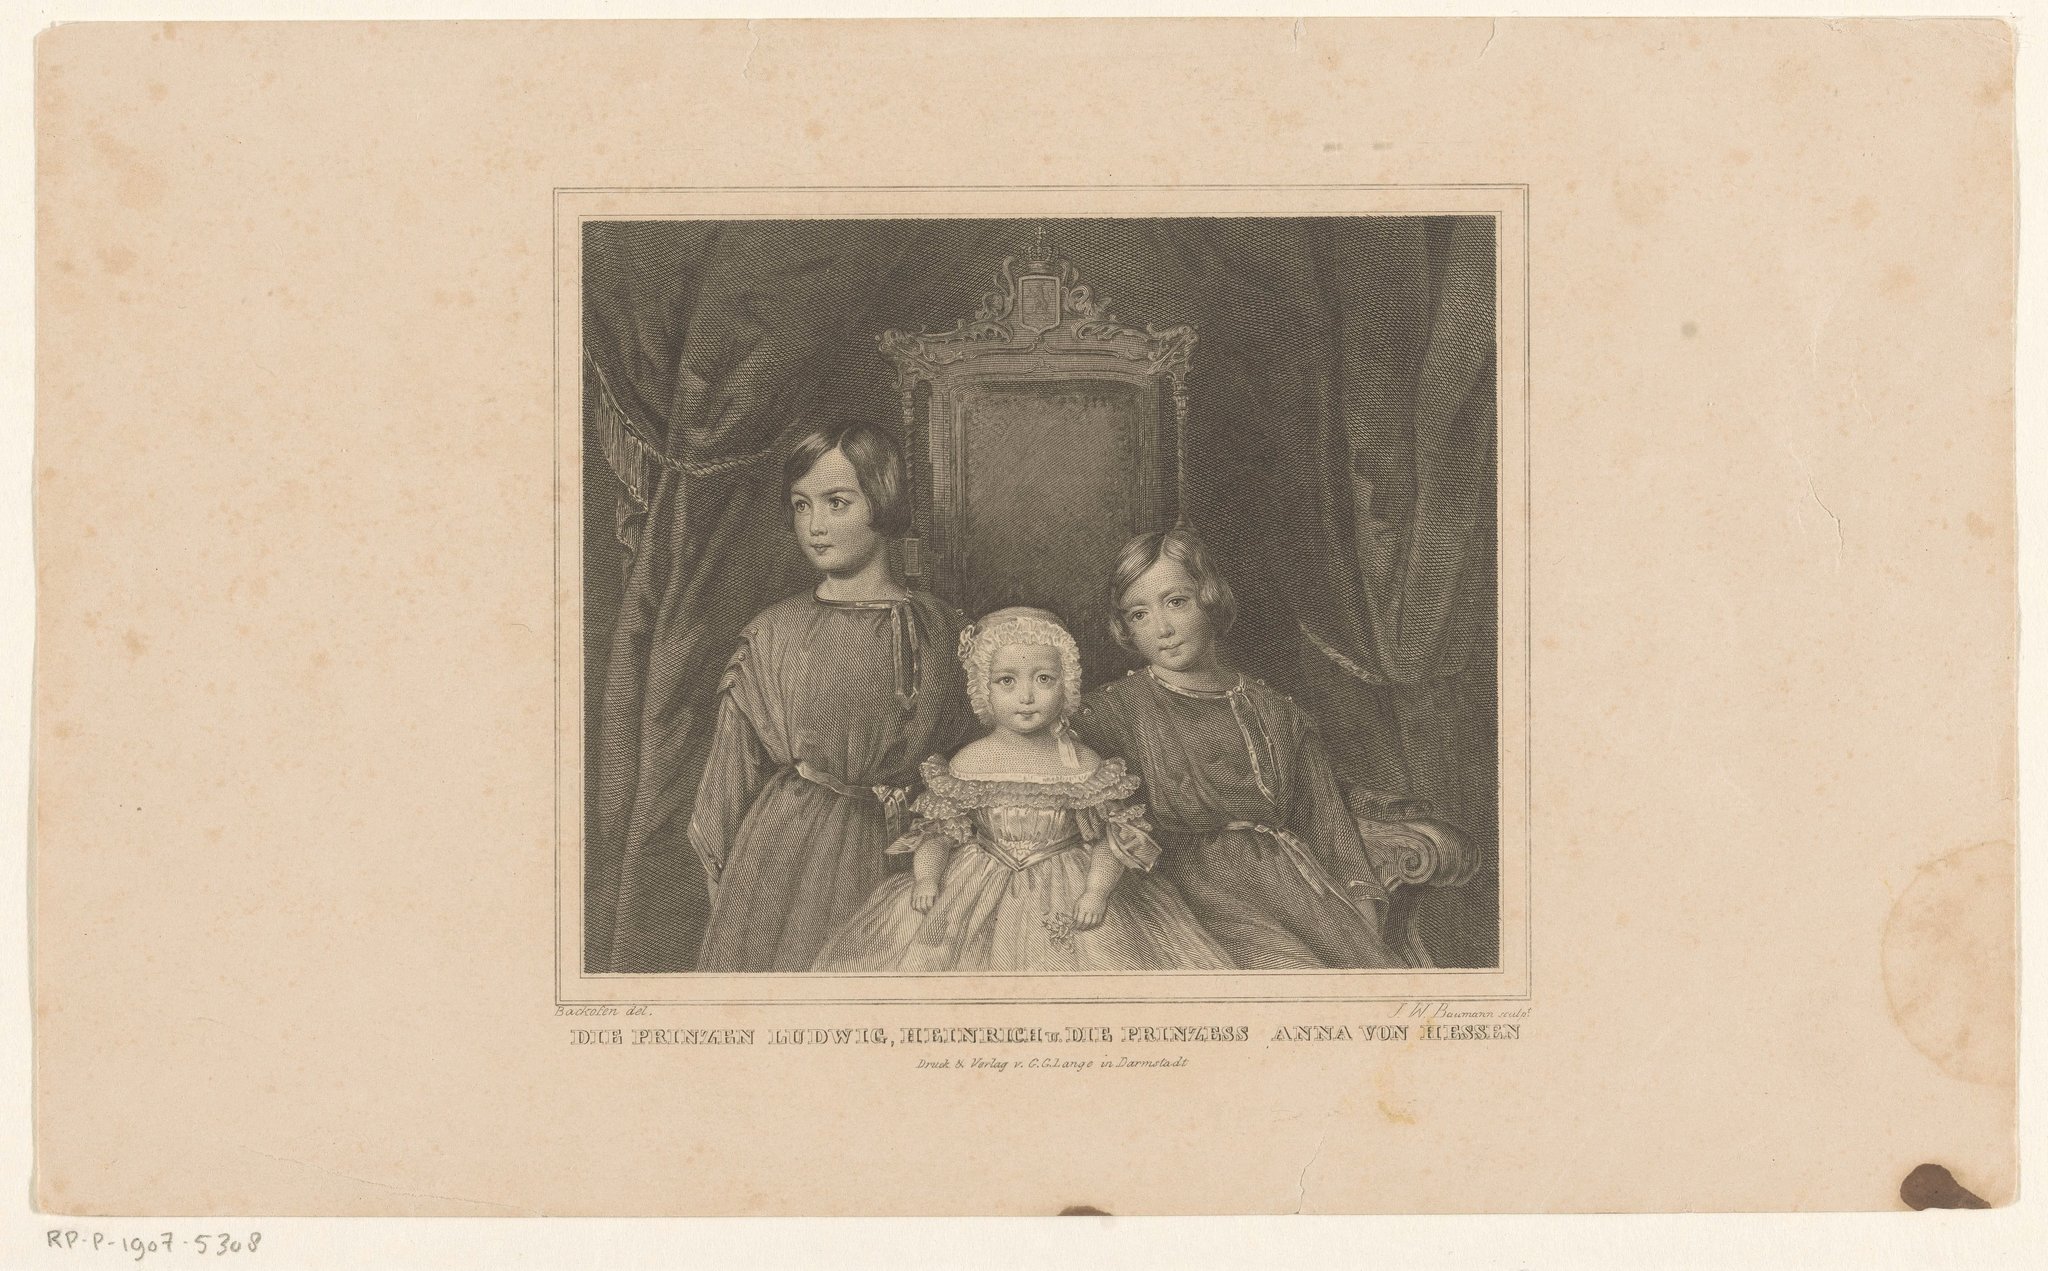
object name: print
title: Groepsportret met Ludwig, Heinrich en Anna van Hessen als kinderen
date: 1843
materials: paper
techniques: engraving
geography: darmstadt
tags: historical persons - bb - woman, historical persons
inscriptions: collector's mark: Lugt 2228